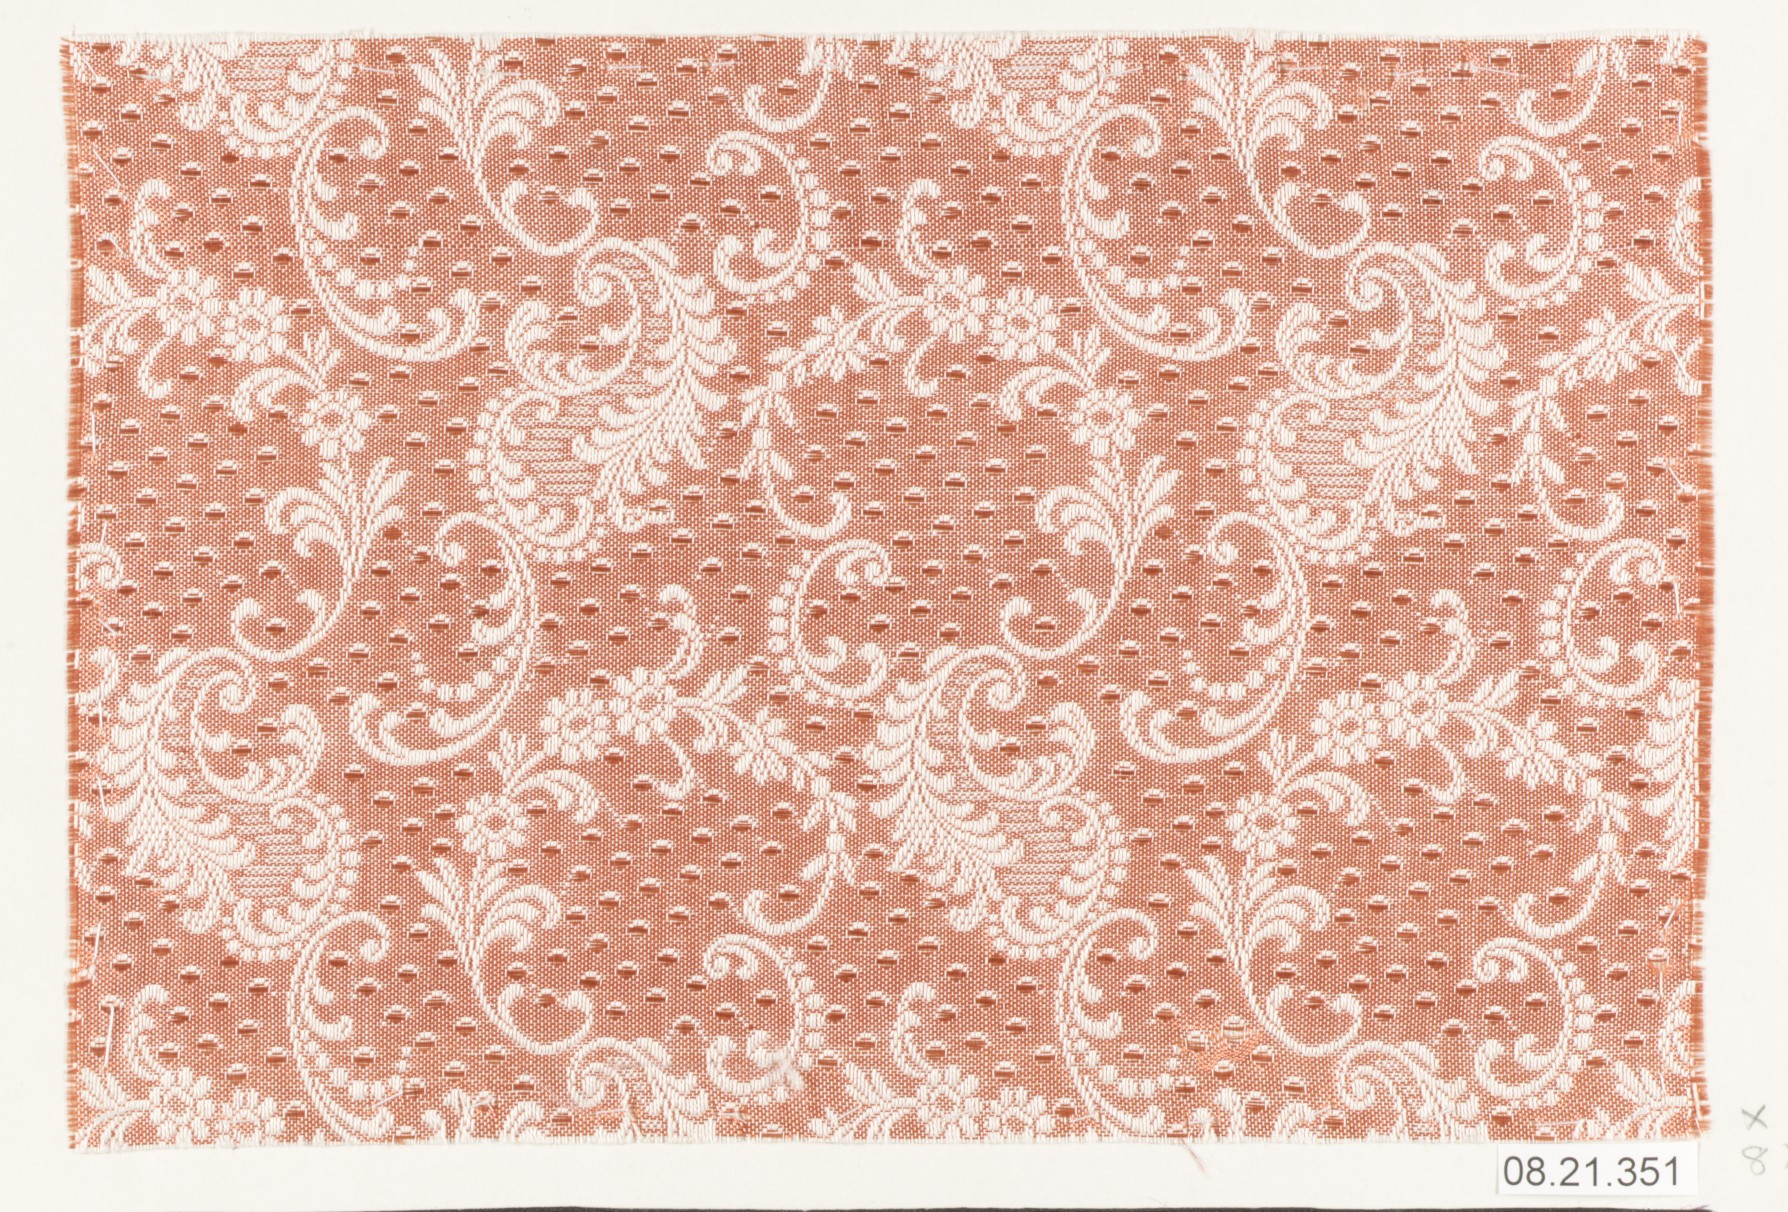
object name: textile sample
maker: Anonymous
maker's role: designer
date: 1900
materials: silk